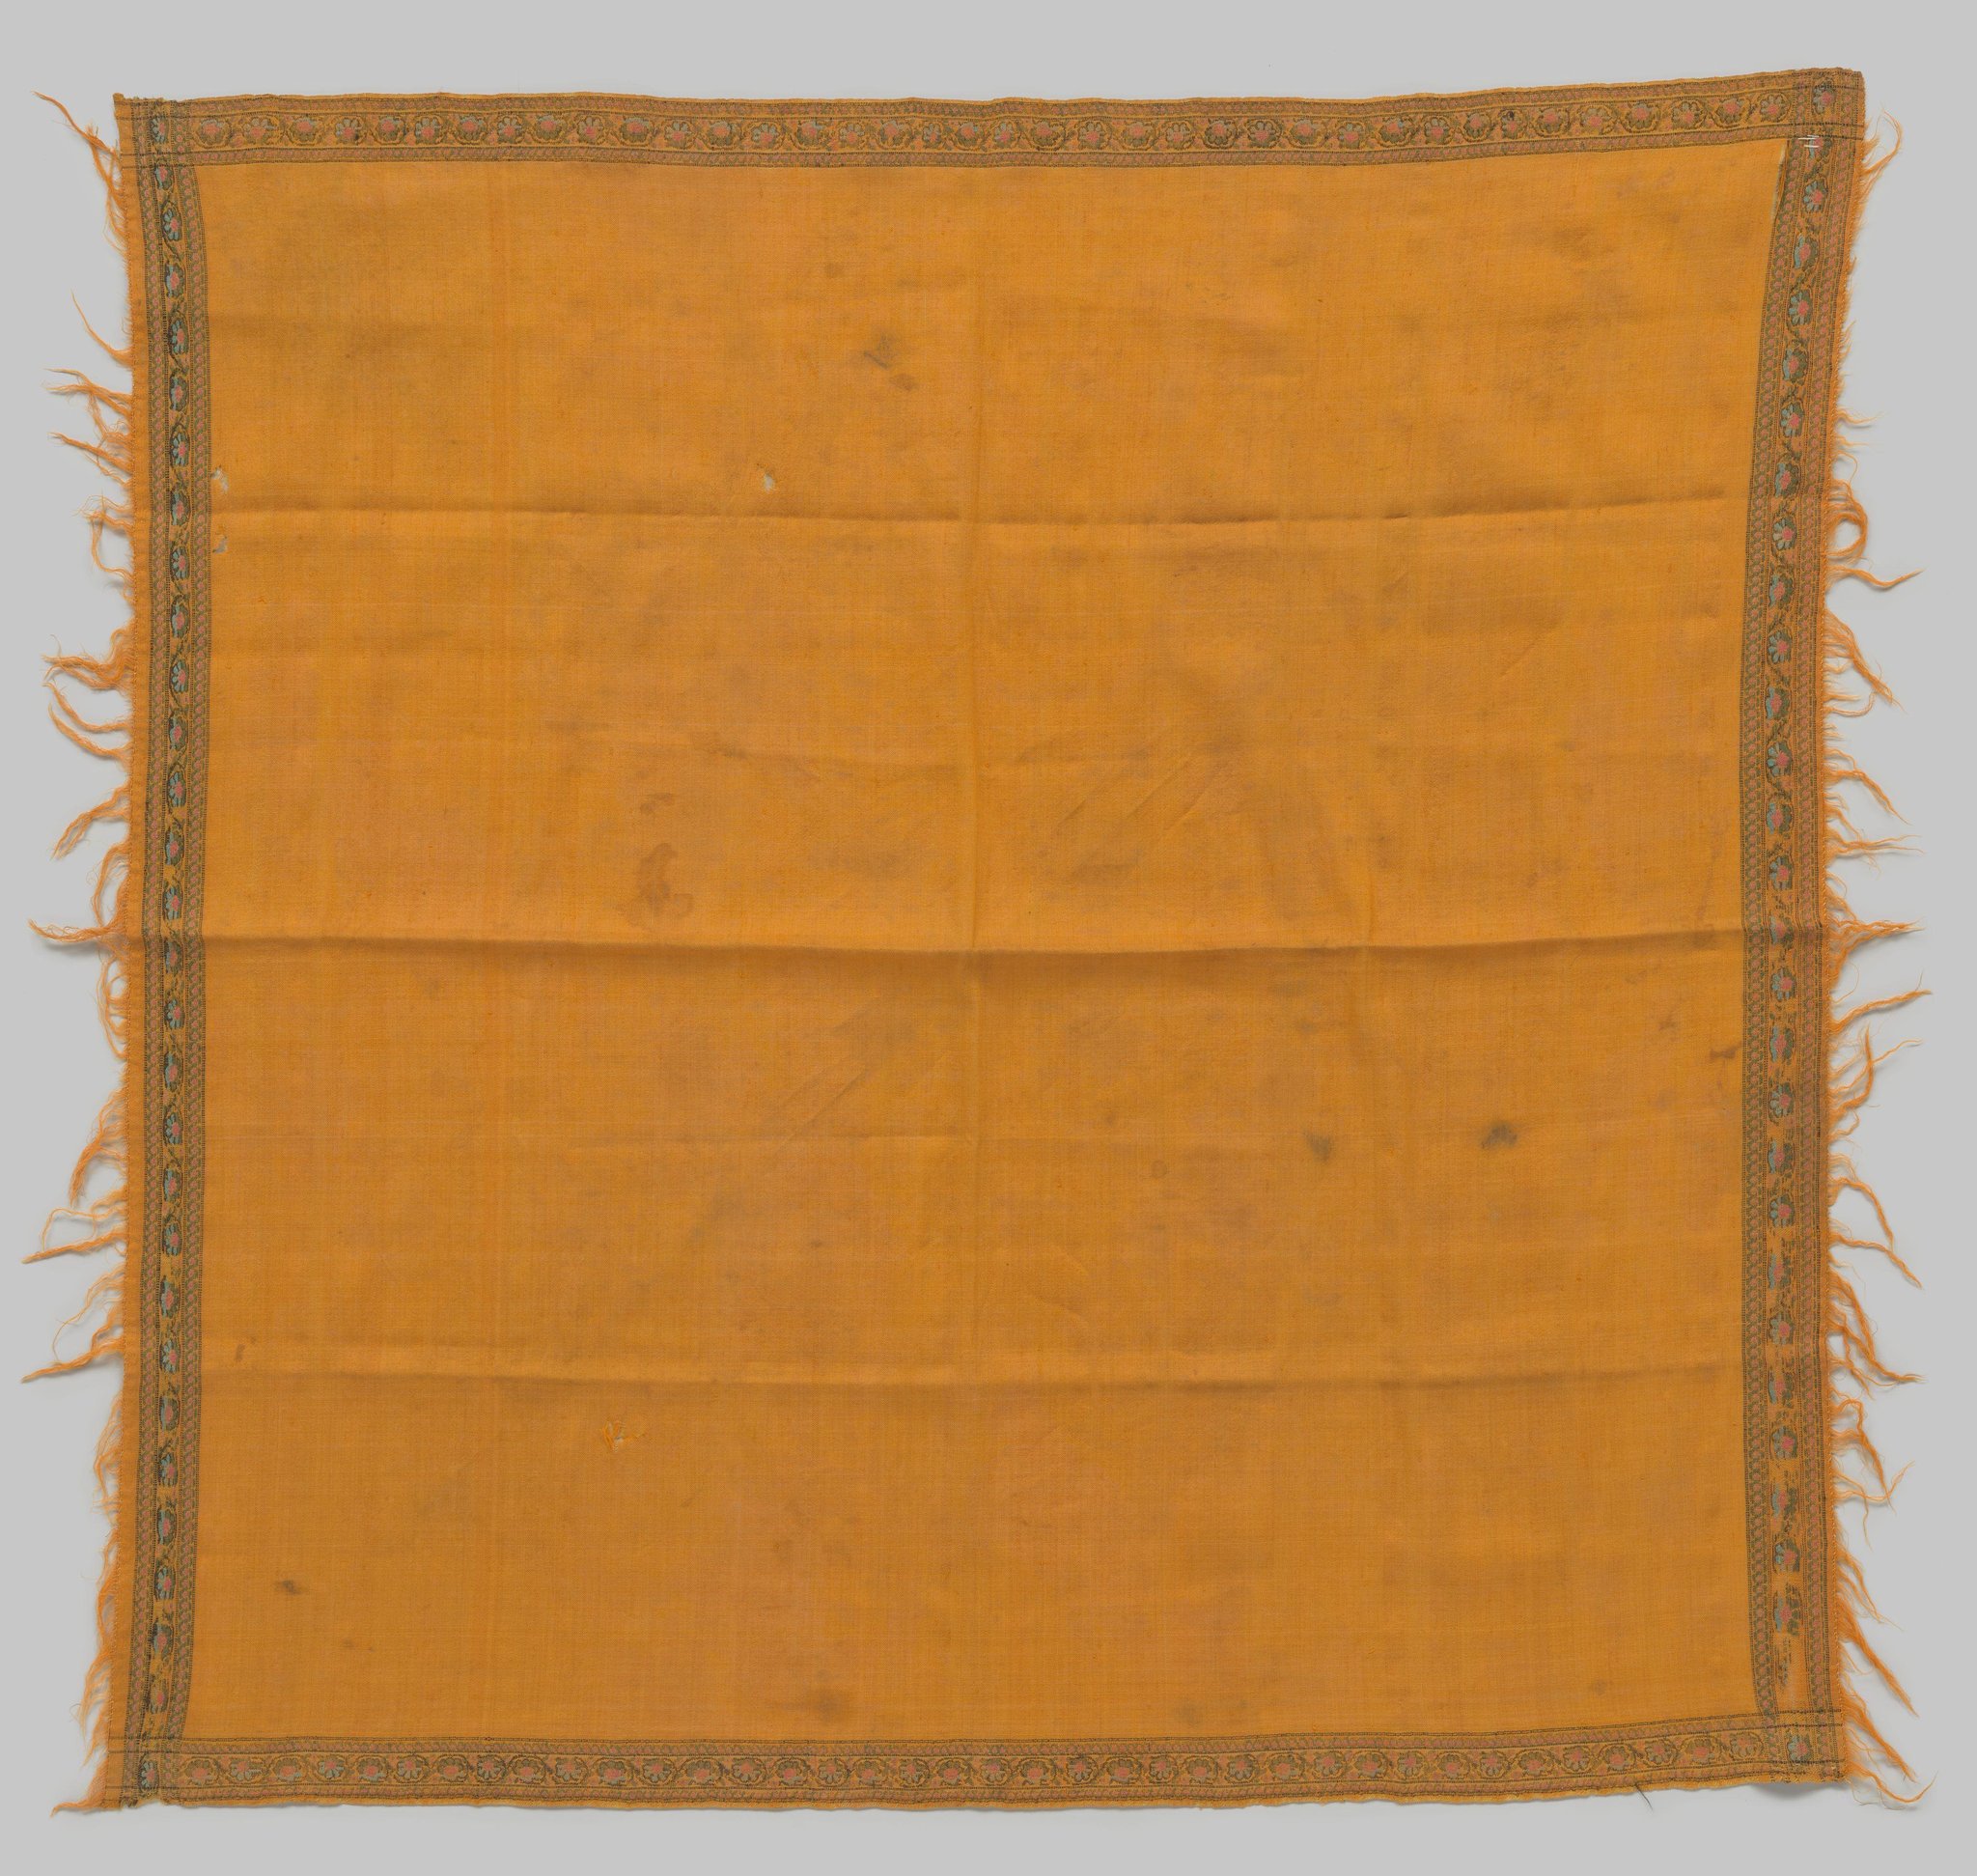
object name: scarf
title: Vierkante kasjmiersjaal met effen oranje fond, waarlangs een smalle band met aaneengesloten bloemen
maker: Anonymous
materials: wool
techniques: weave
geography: western europe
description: Vierkante kasjmiersjaal van wol met effen oranje fond, waarlangs een smalle band met aaneengesloten bloemen binnen een lijst van groene en roze motieven. Langs twee randen korte oranje franje aangenaaid.